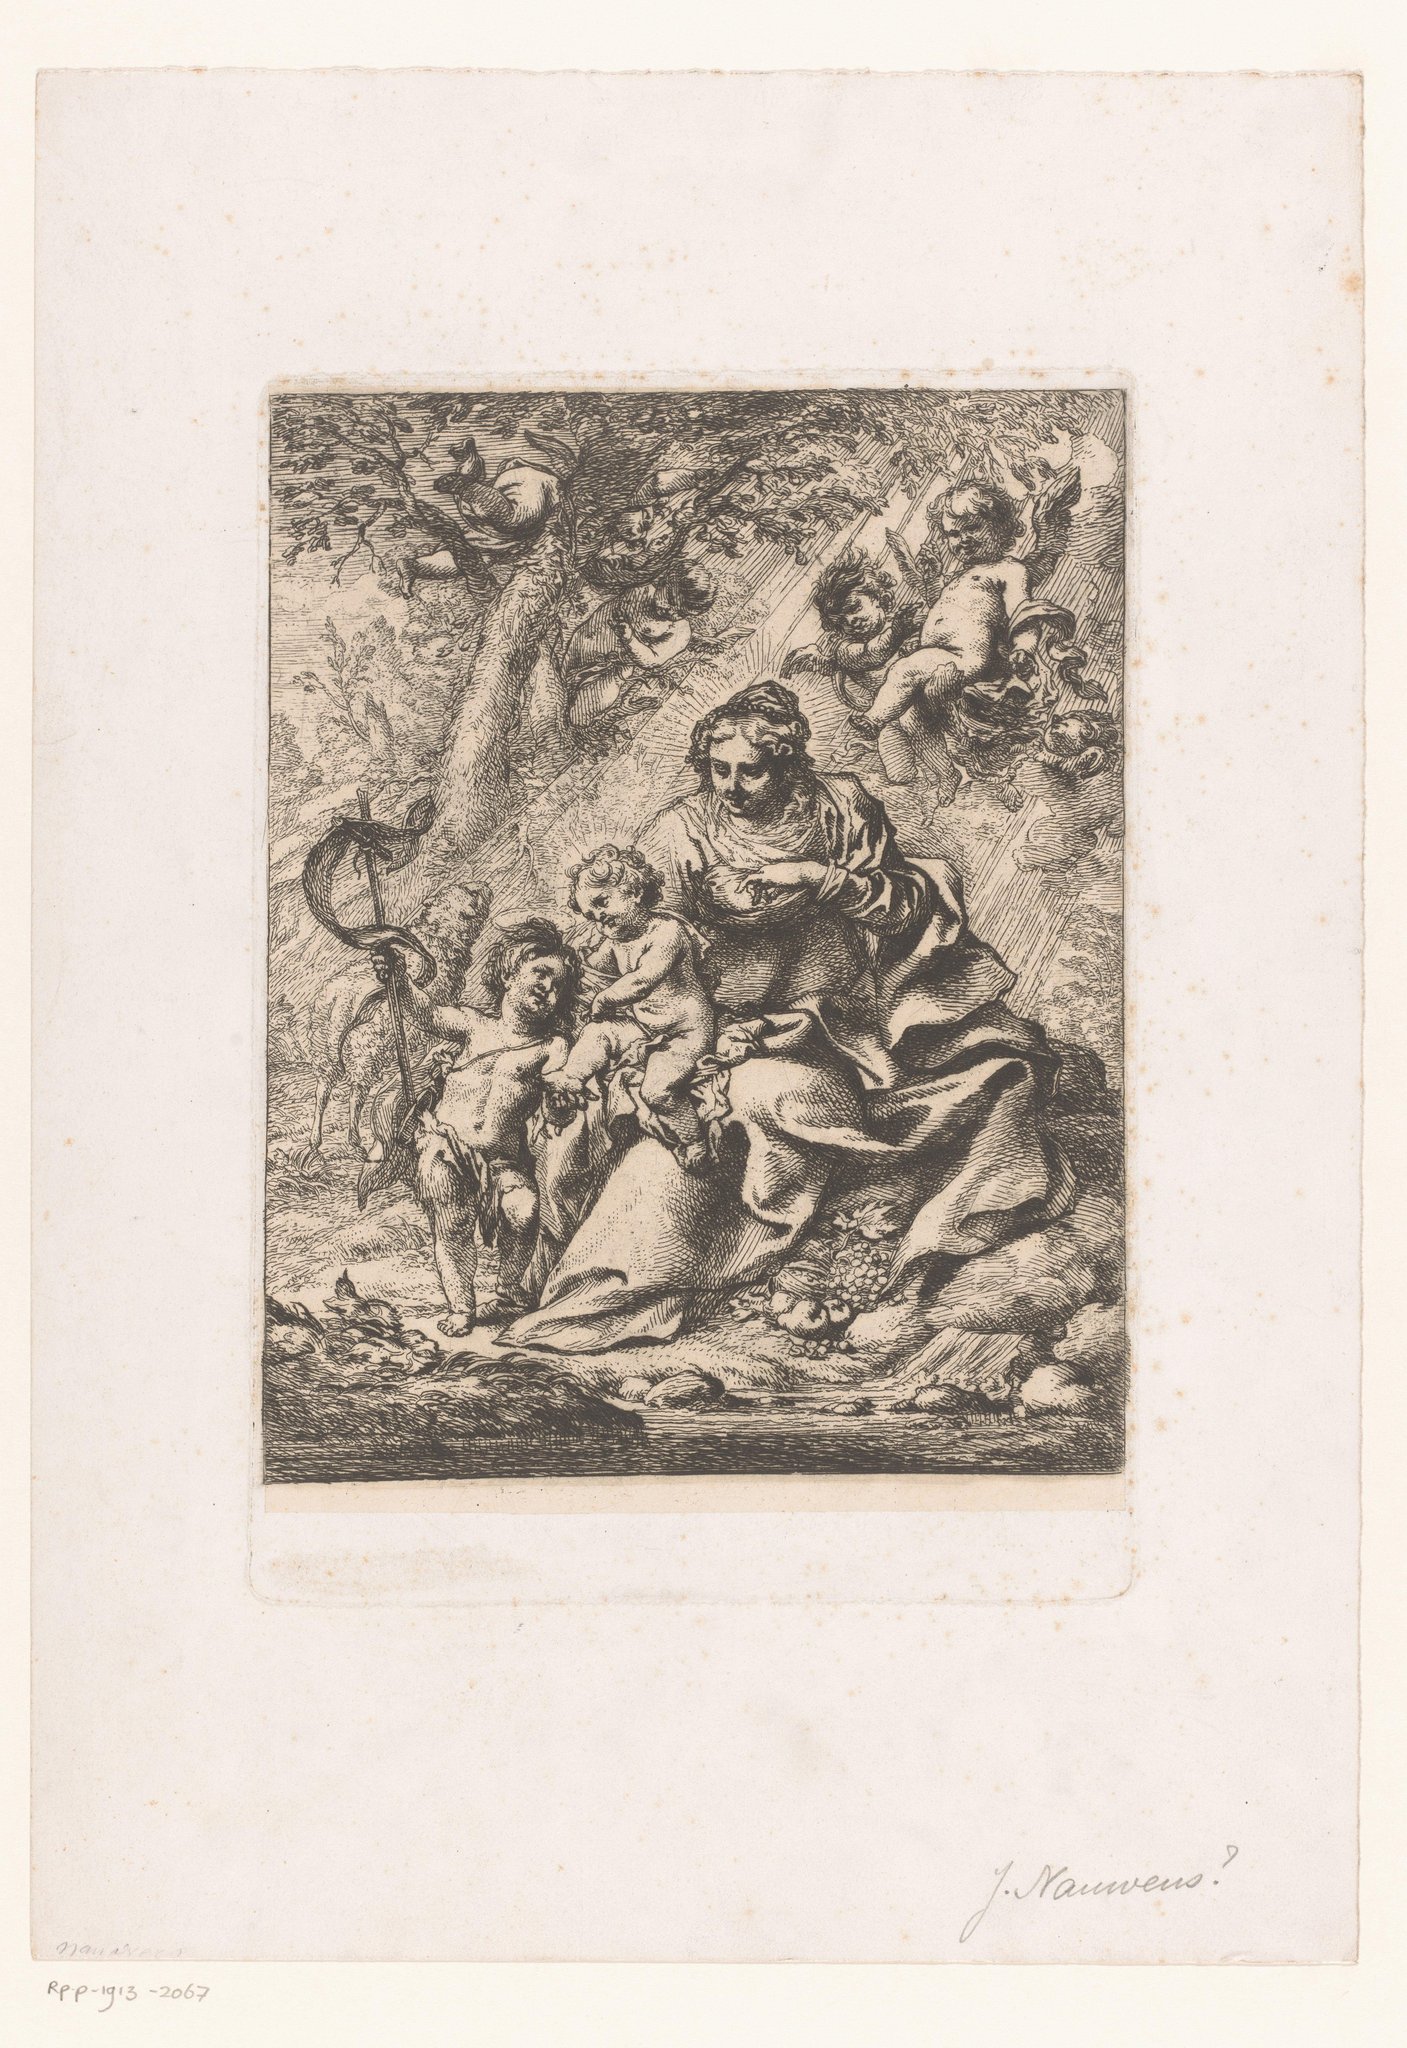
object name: print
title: Maria met Christus en Johannes de Doper als kinderen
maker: josephus nauwens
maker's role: print maker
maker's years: 1830-1906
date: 1840-1886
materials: paper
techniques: etching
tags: mary and the christ-child with john the baptist (as child) (+ angel(s))